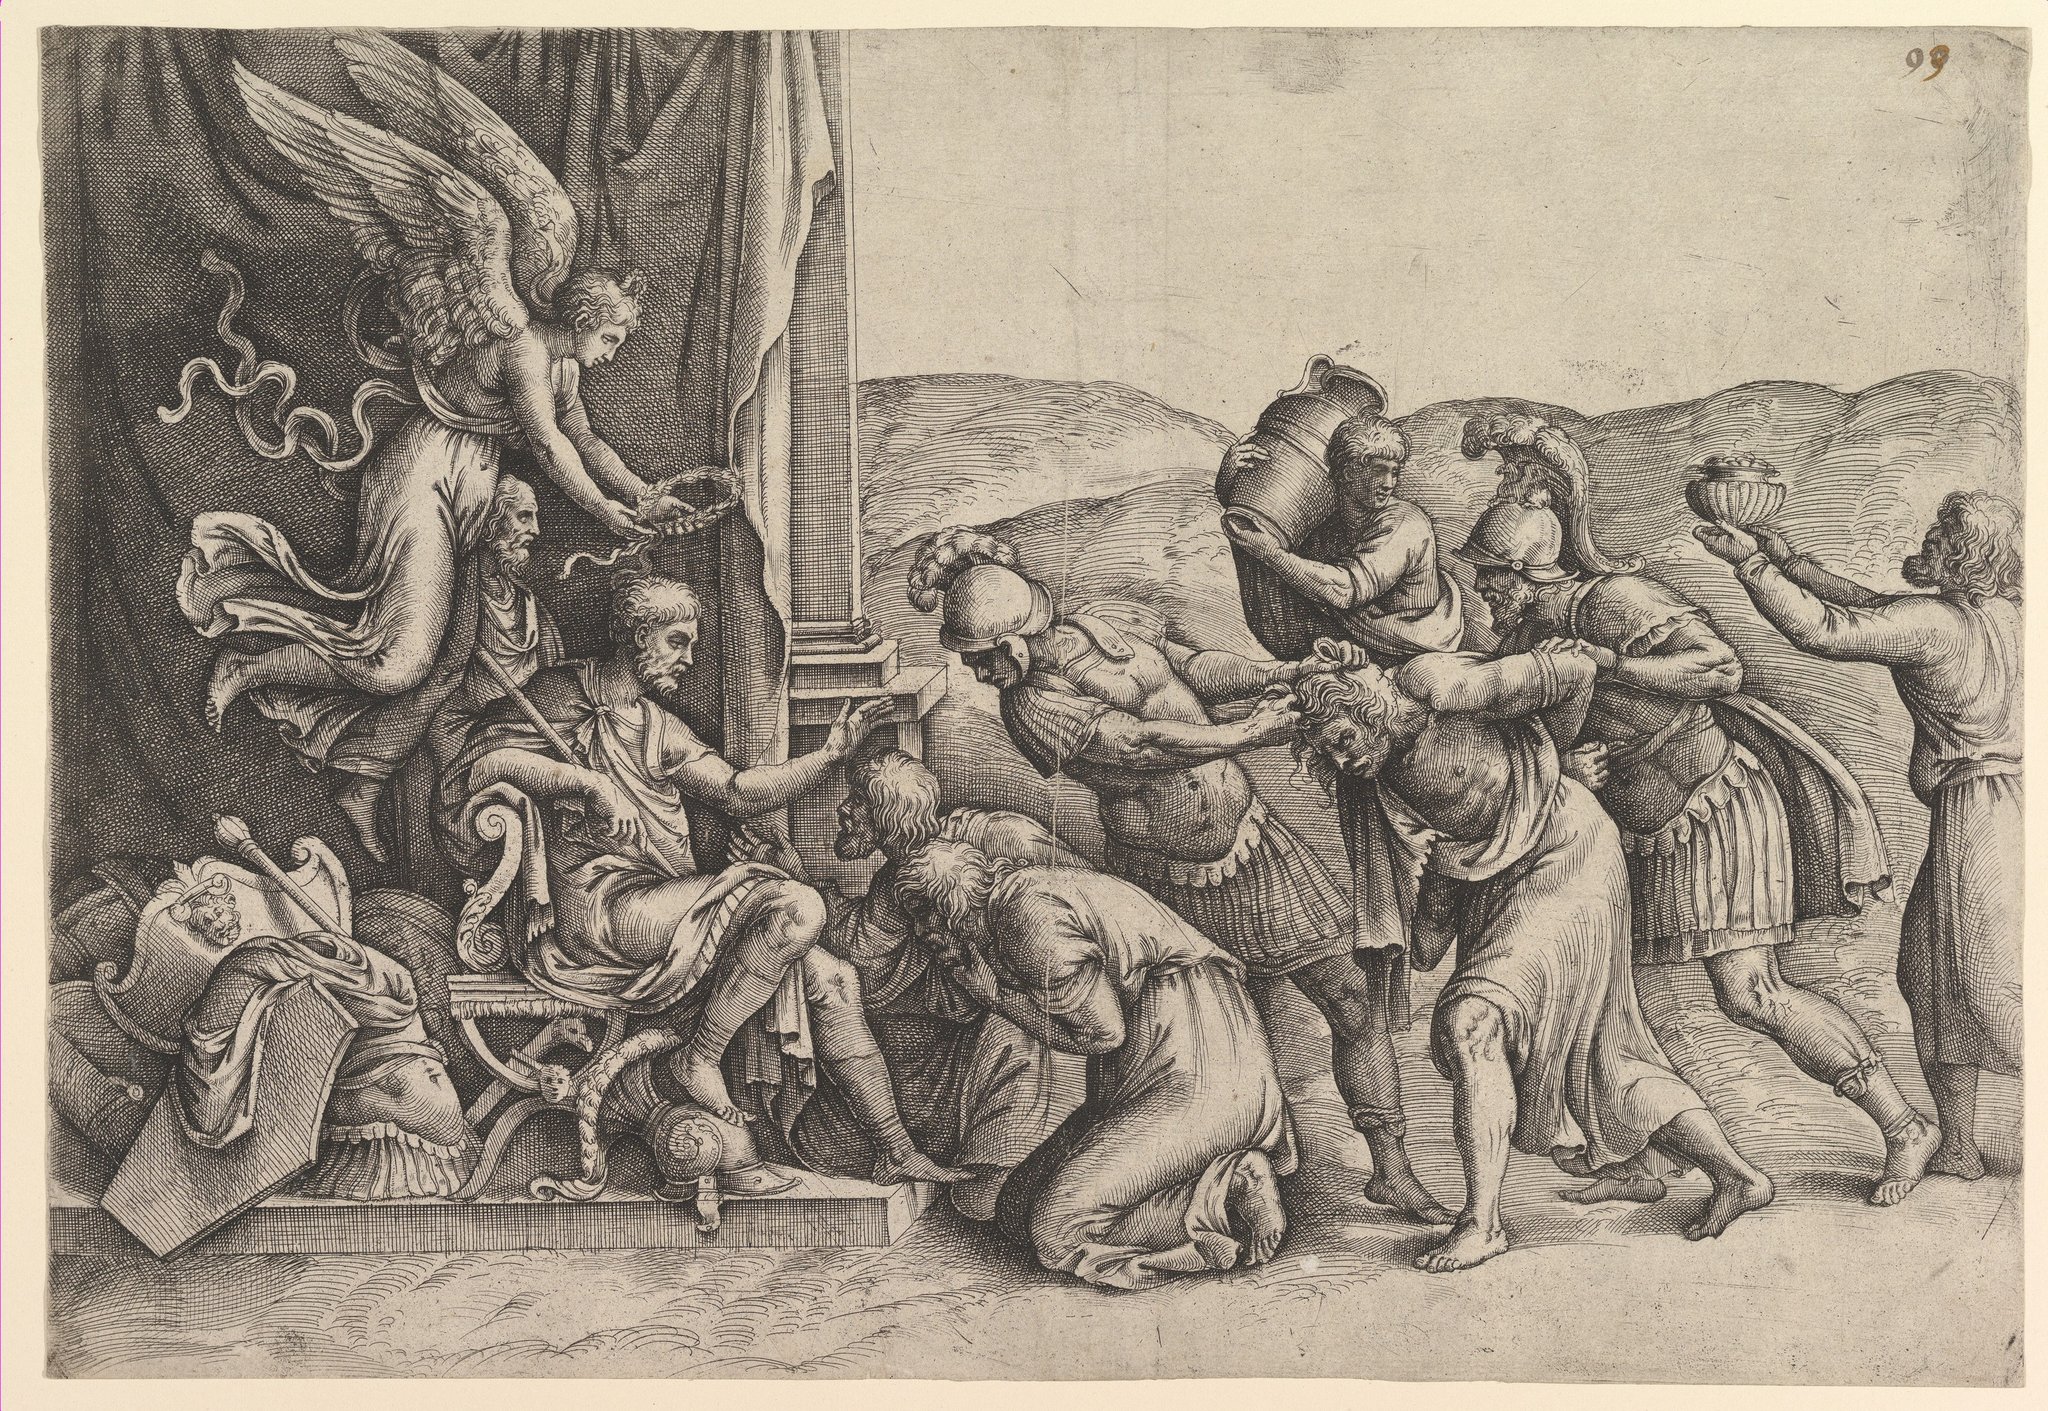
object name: print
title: Scipio Granting Clemency to the Prisoners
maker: battista franco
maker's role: artist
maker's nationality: italian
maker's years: 1510-1561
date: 1501-1600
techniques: engraving, etching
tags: soldiers,prisoners,punishment